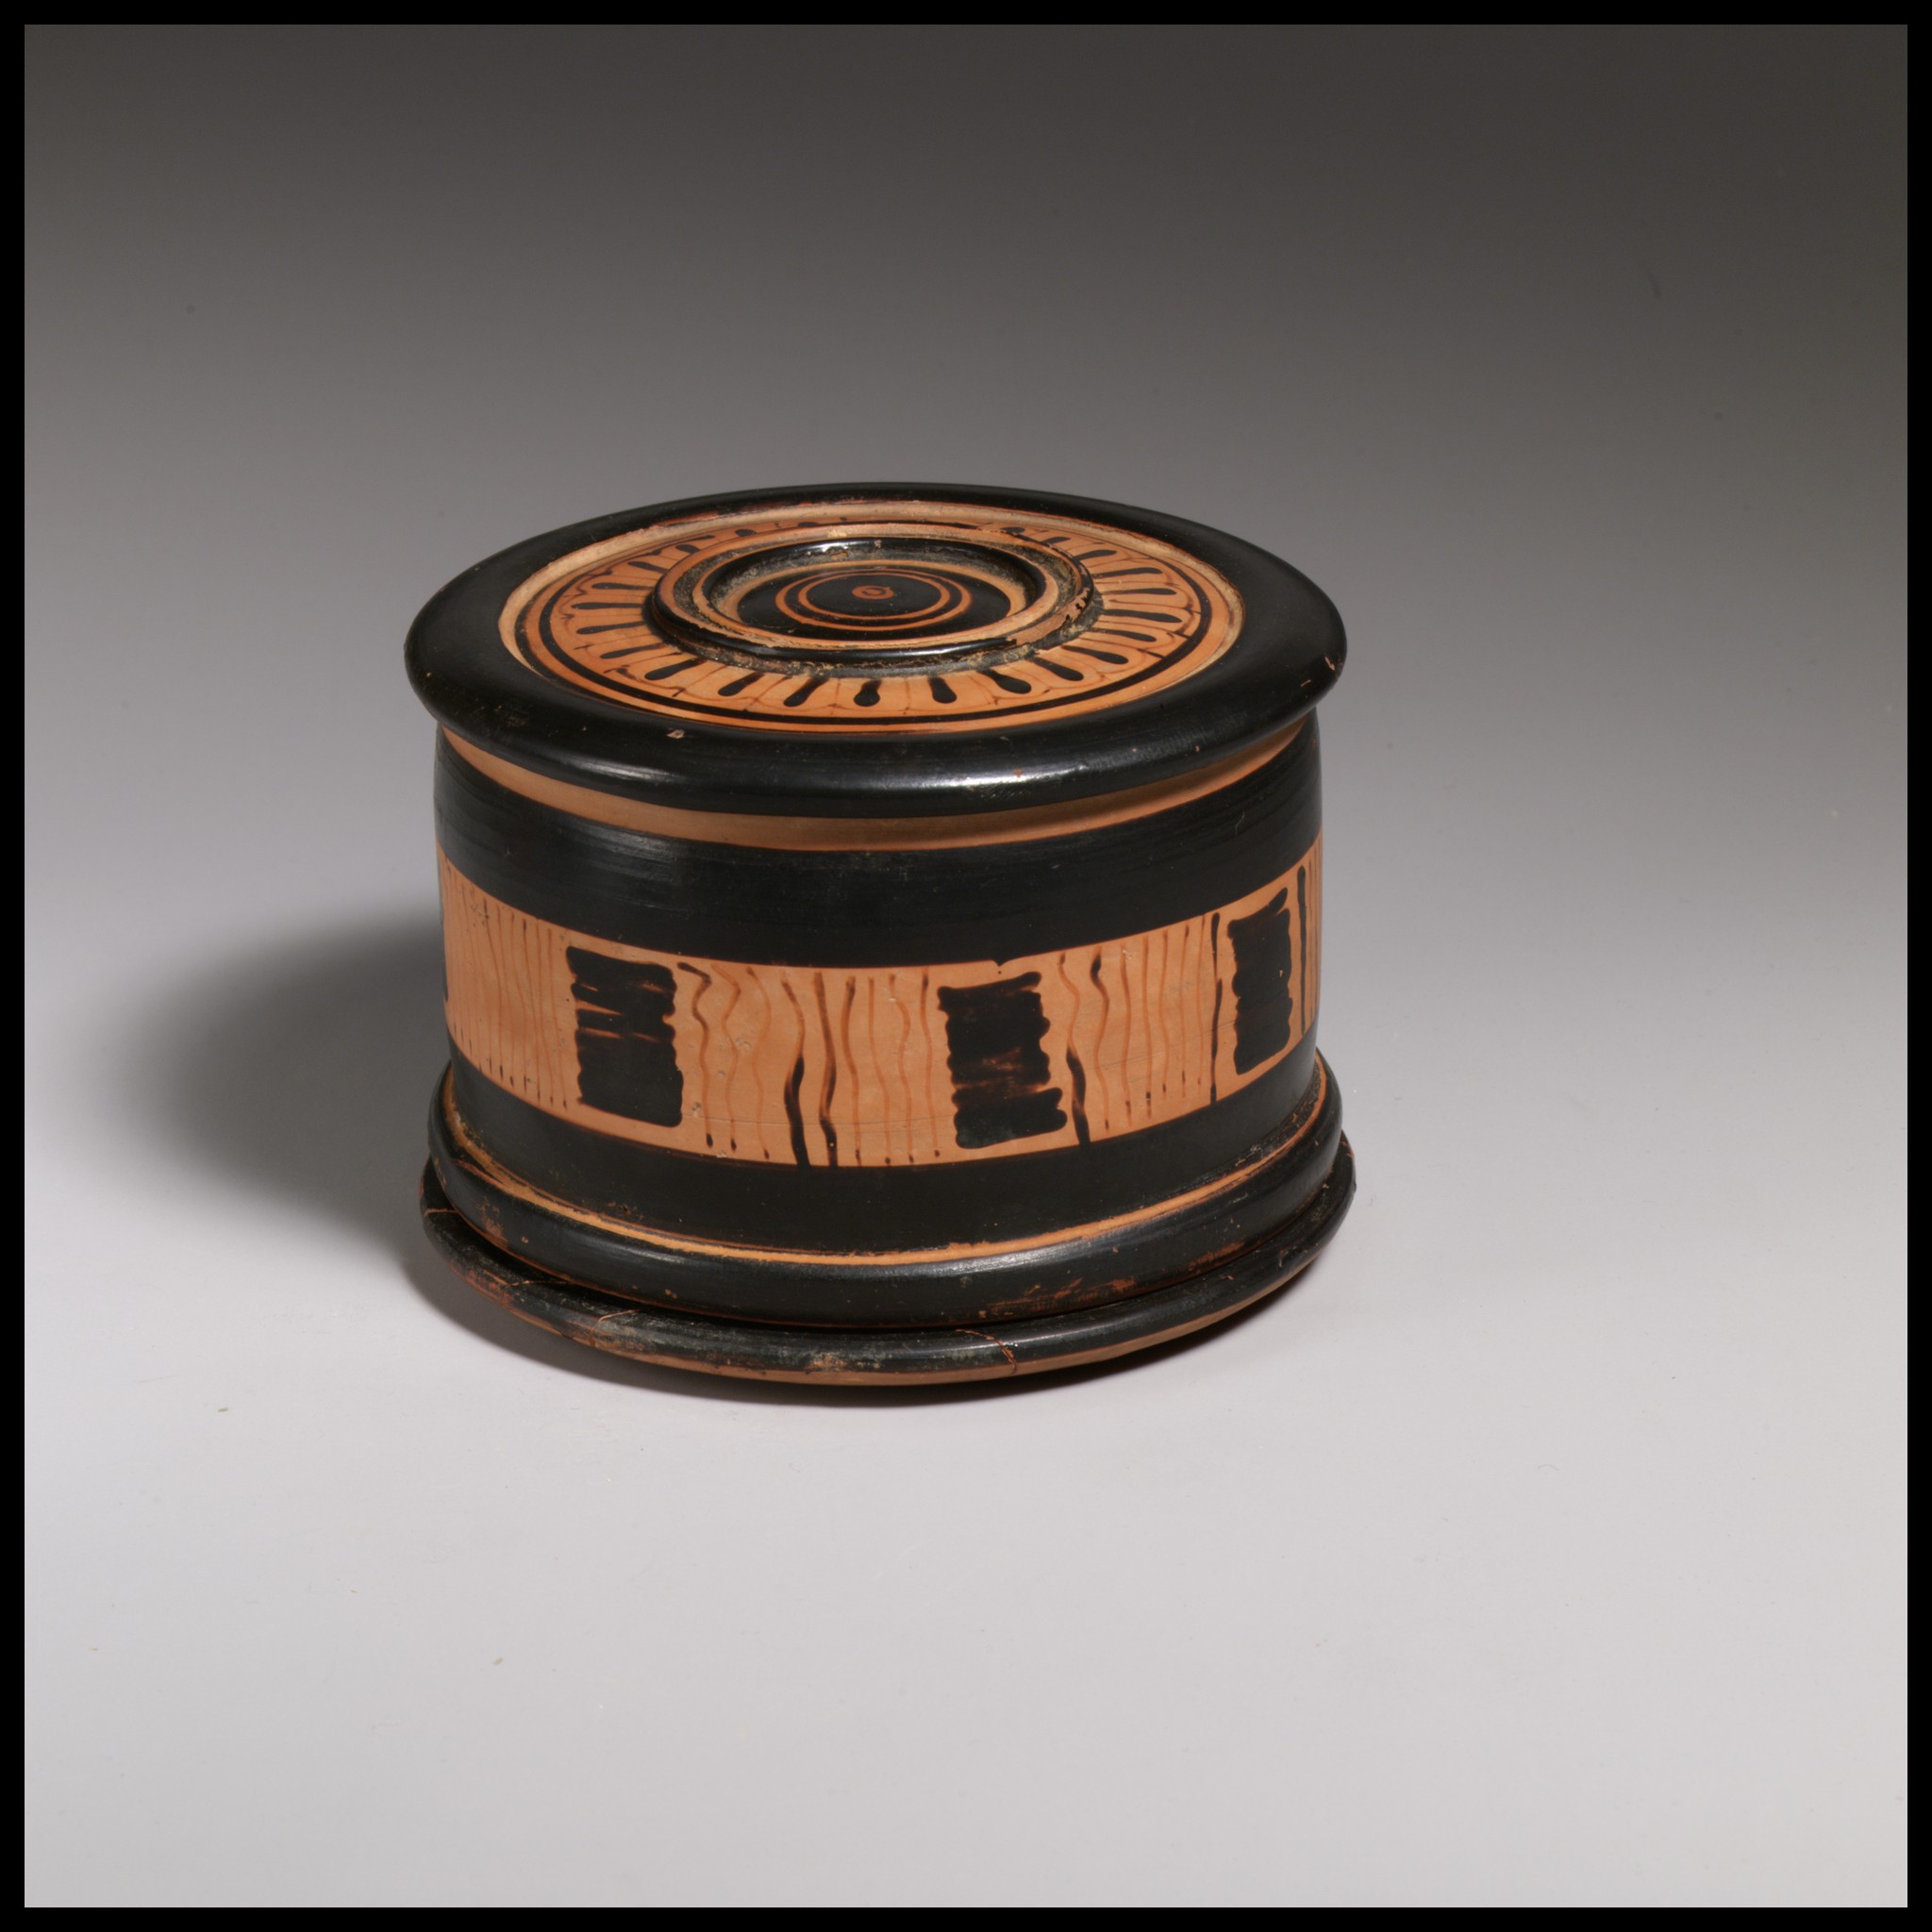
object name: pyxis with lid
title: Terracotta pyxis (cosmetic box)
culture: greek, boeotian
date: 600-501 BCE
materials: terracotta